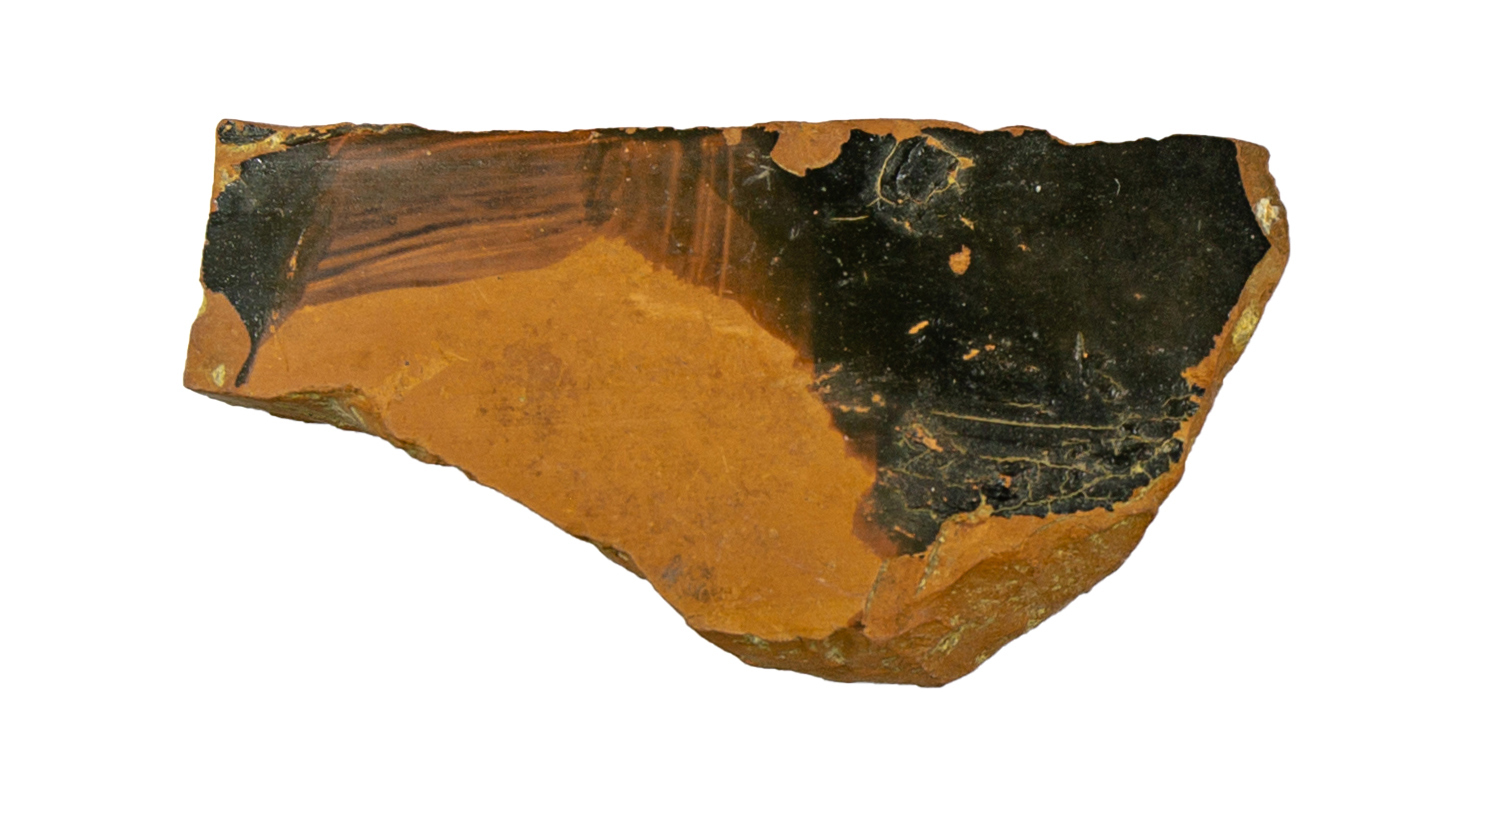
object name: volute krater fragment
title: Volute-krater fragment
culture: greek, south italian, apulian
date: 400-301 BCE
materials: terracotta